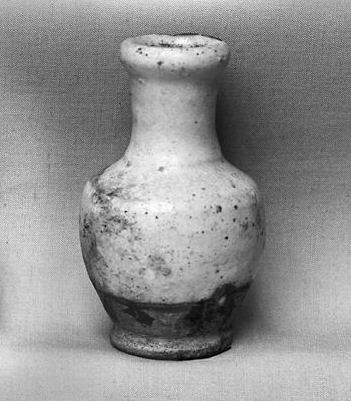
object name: vase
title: Miniature vase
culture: chinese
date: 618-907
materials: ceramic, glaze